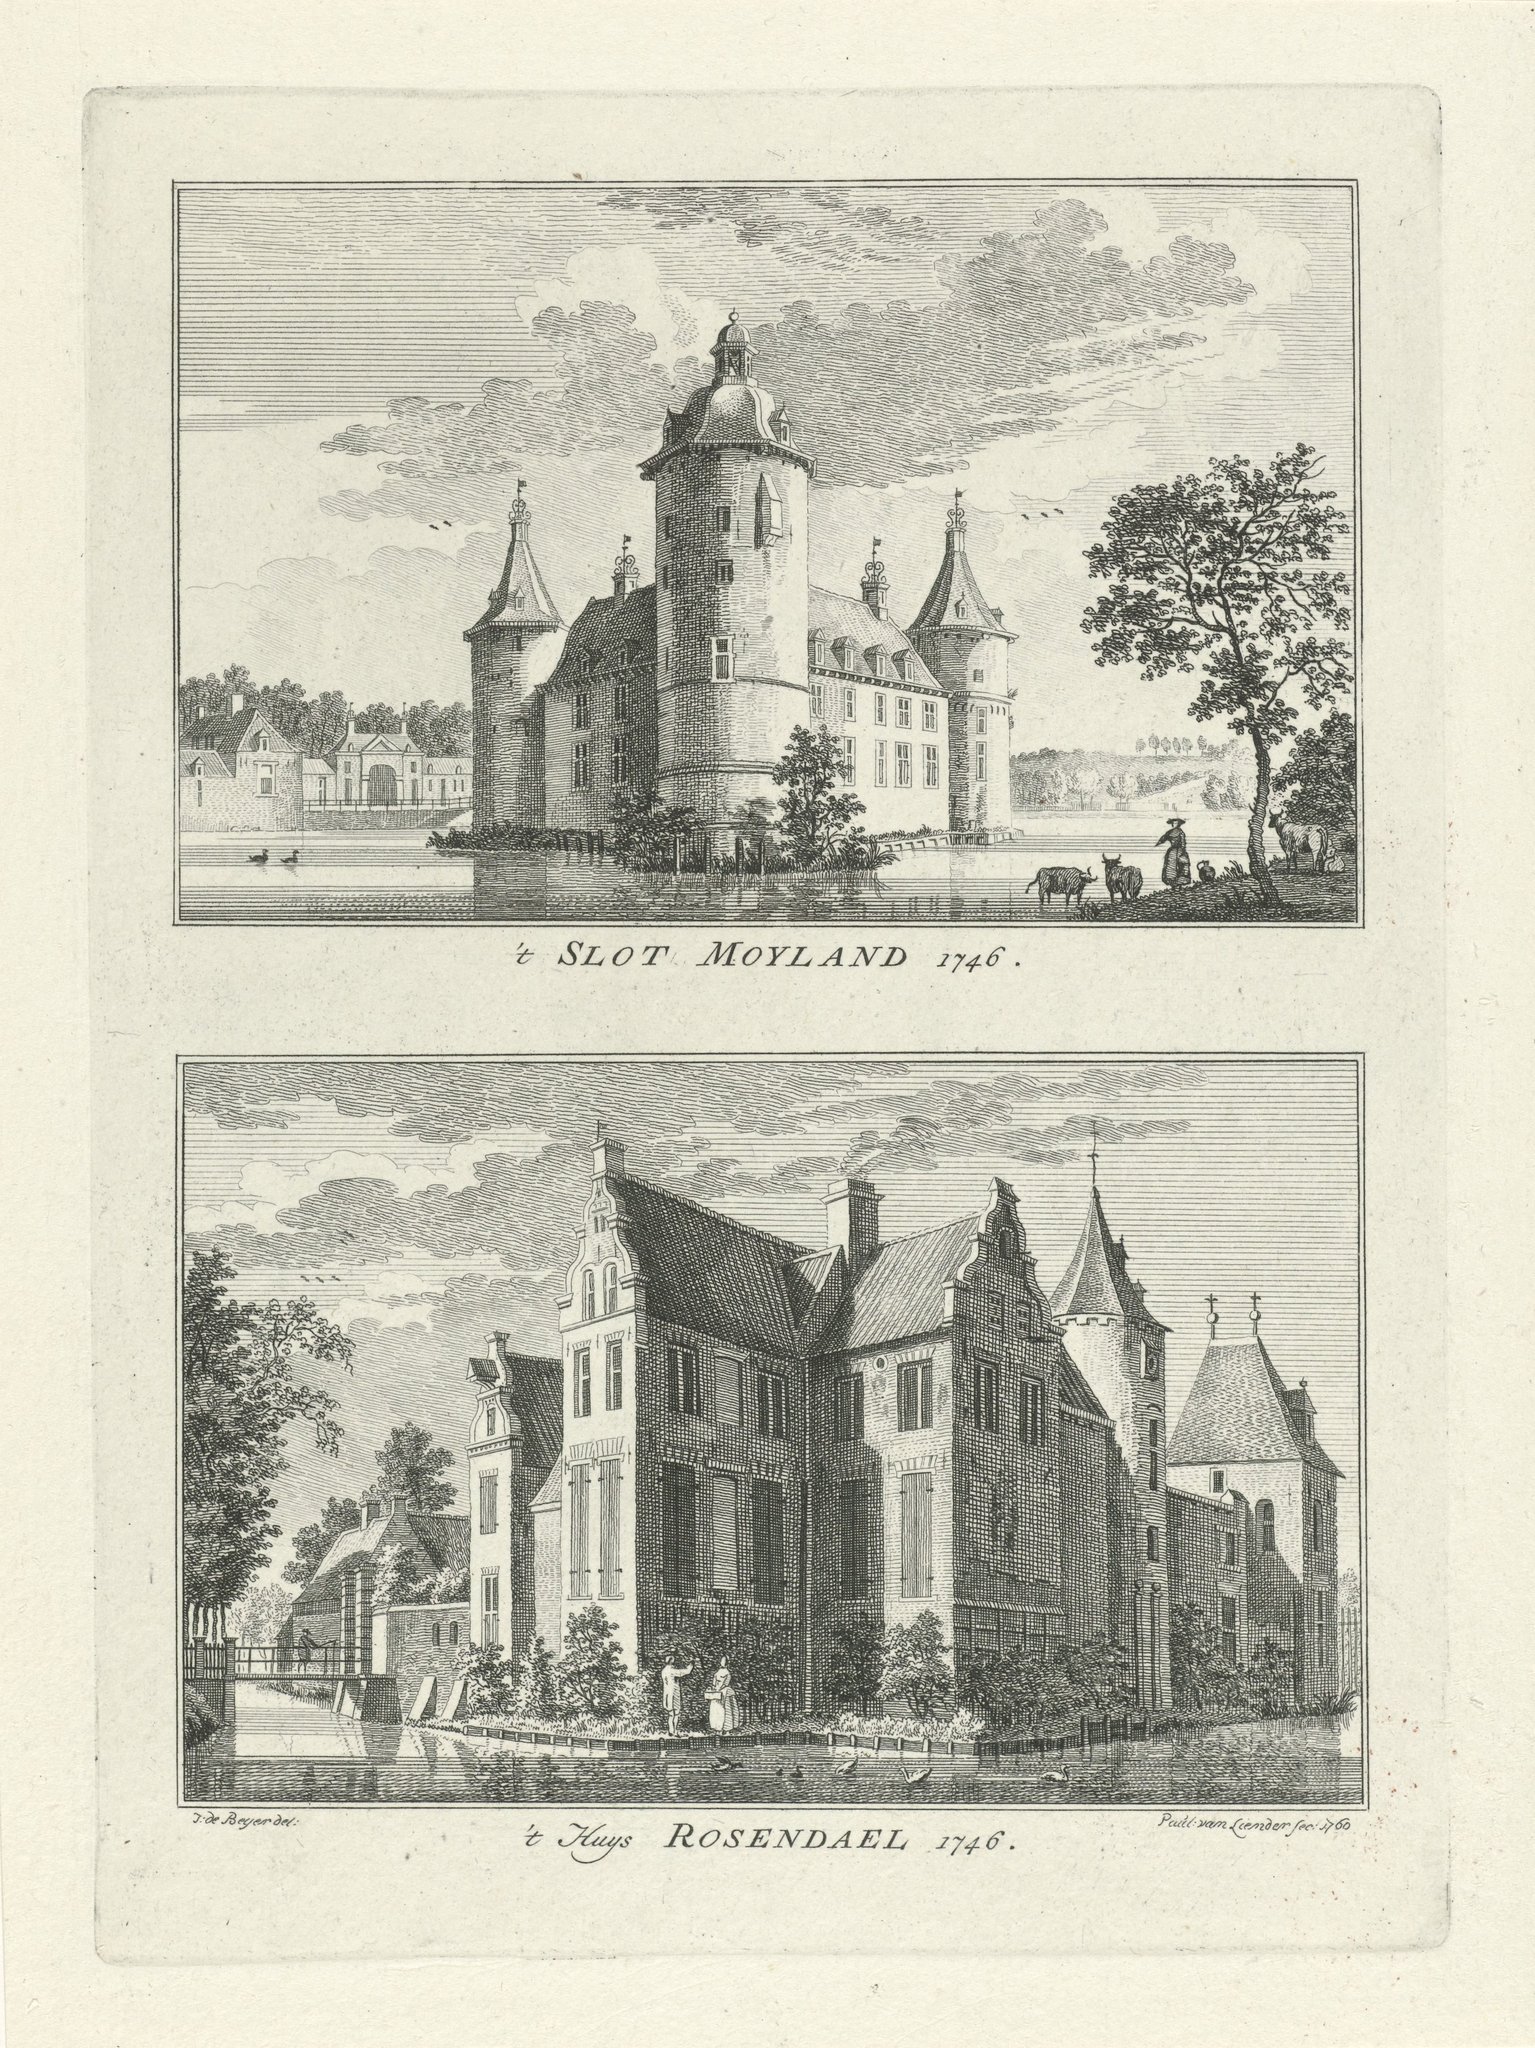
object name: print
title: 't Slot Moyland 1746 / 't Huys Rosendael 1746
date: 1760-1792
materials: paper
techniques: etching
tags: castle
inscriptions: collector's mark: Lugt 240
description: Twee voorstellingen van één plaat. Gezicht op Kasteel Moyland te Kleef (boven) en Huis Rosendal te Bedburg-Hau (onder). De prent maakt deel uit van een 100-delige serie met gezichten op dorpen en steden te Kleef.